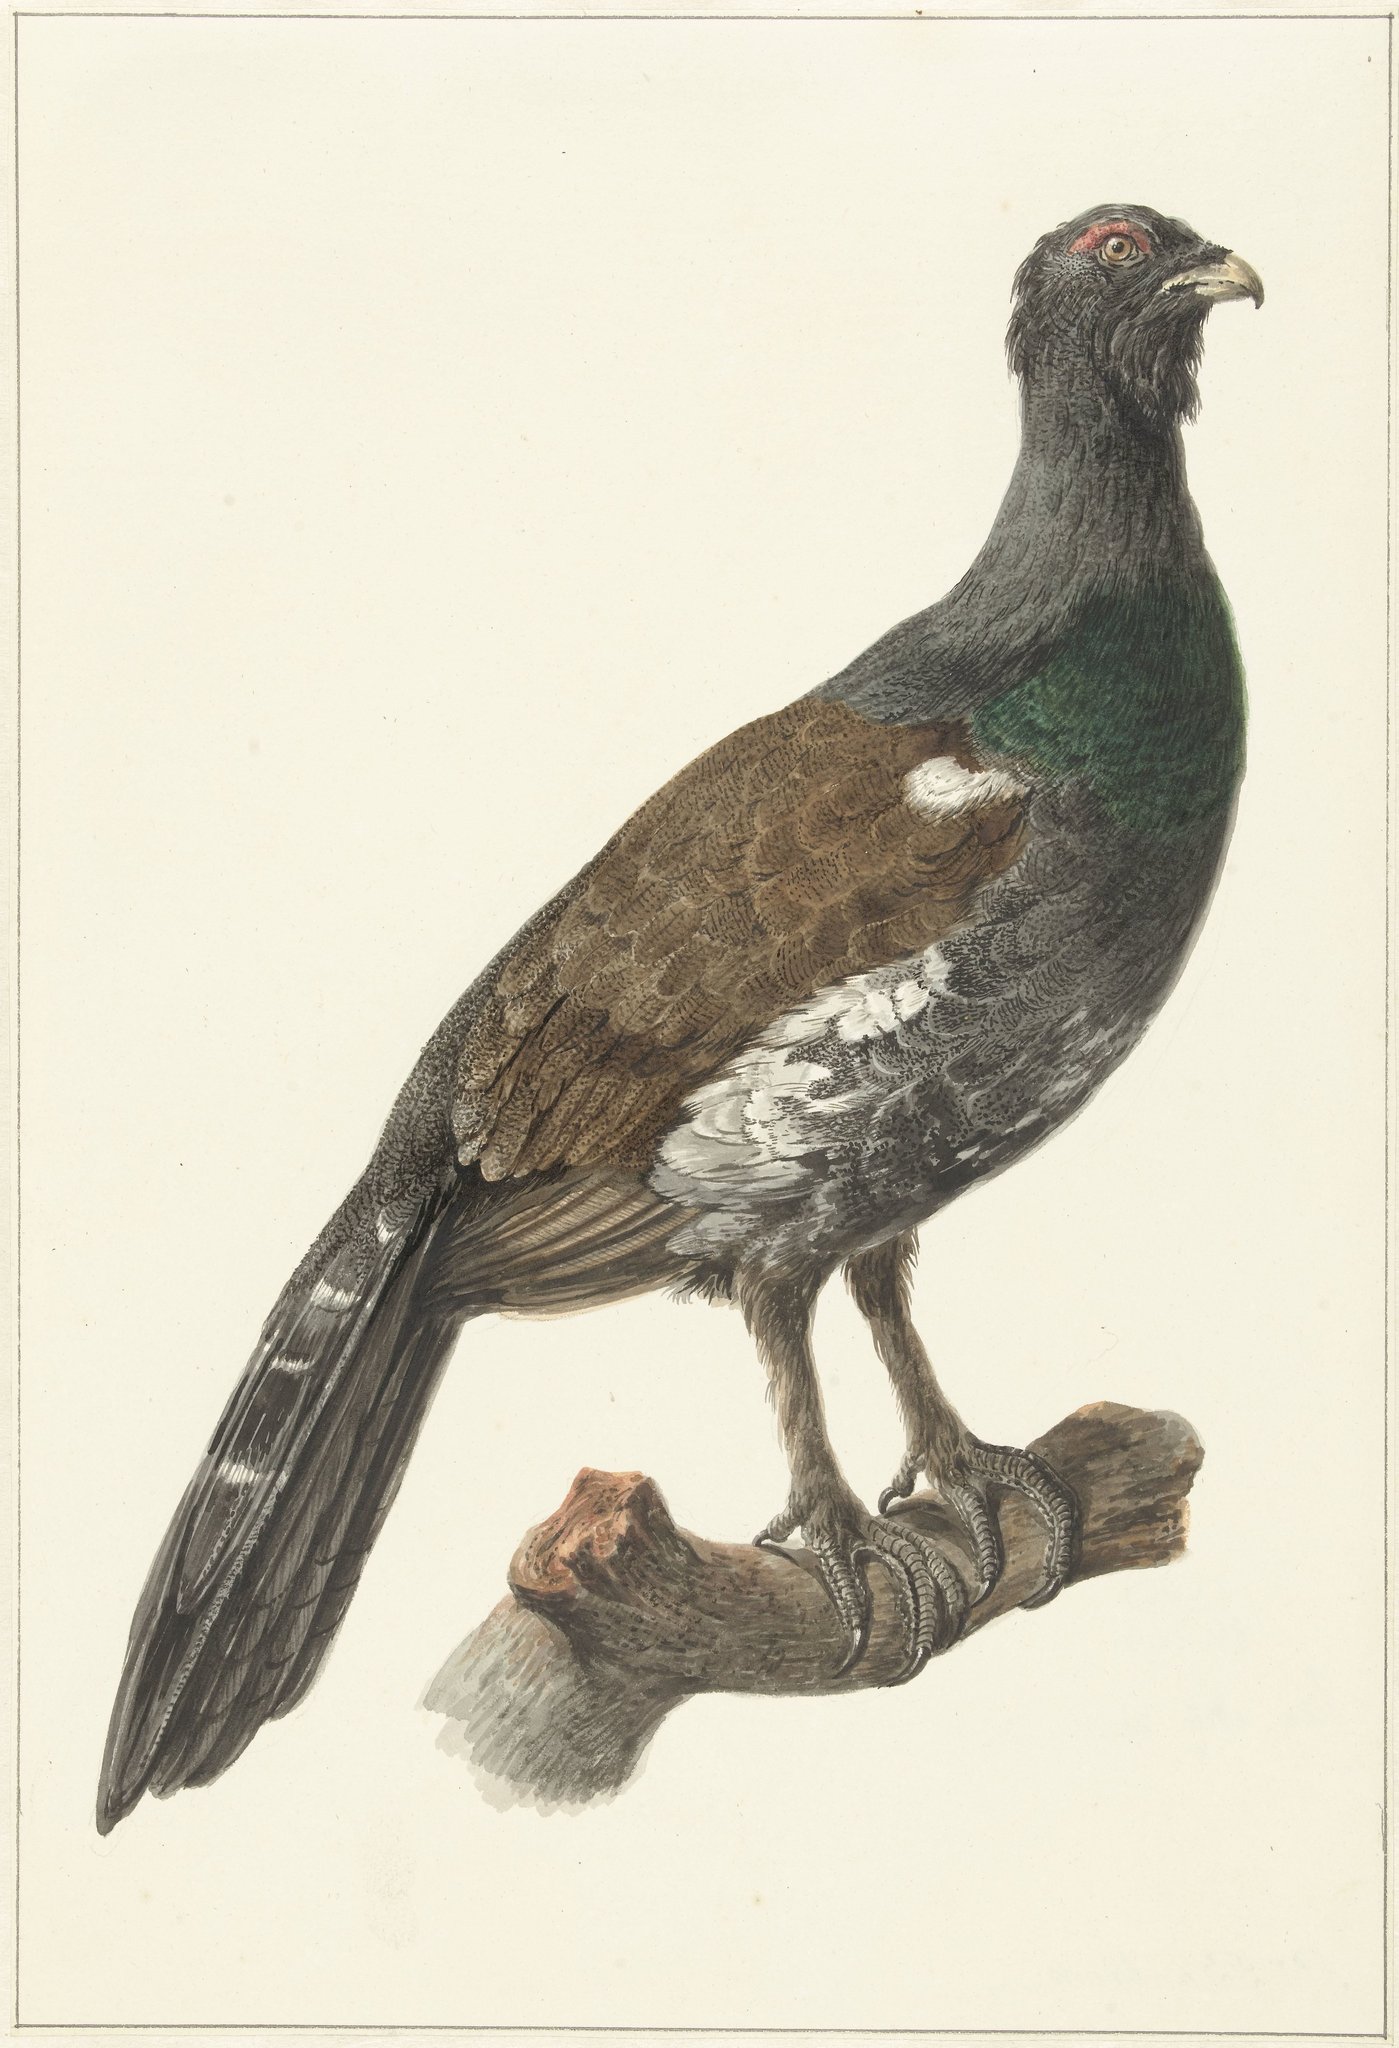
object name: watercolor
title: Auerhaan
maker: pieter pietersz. barbiers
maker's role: draughtsman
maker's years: 1749-1842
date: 1759-1842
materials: paper, pencil, watercolor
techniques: brush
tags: walker and runner birds: capercaillie